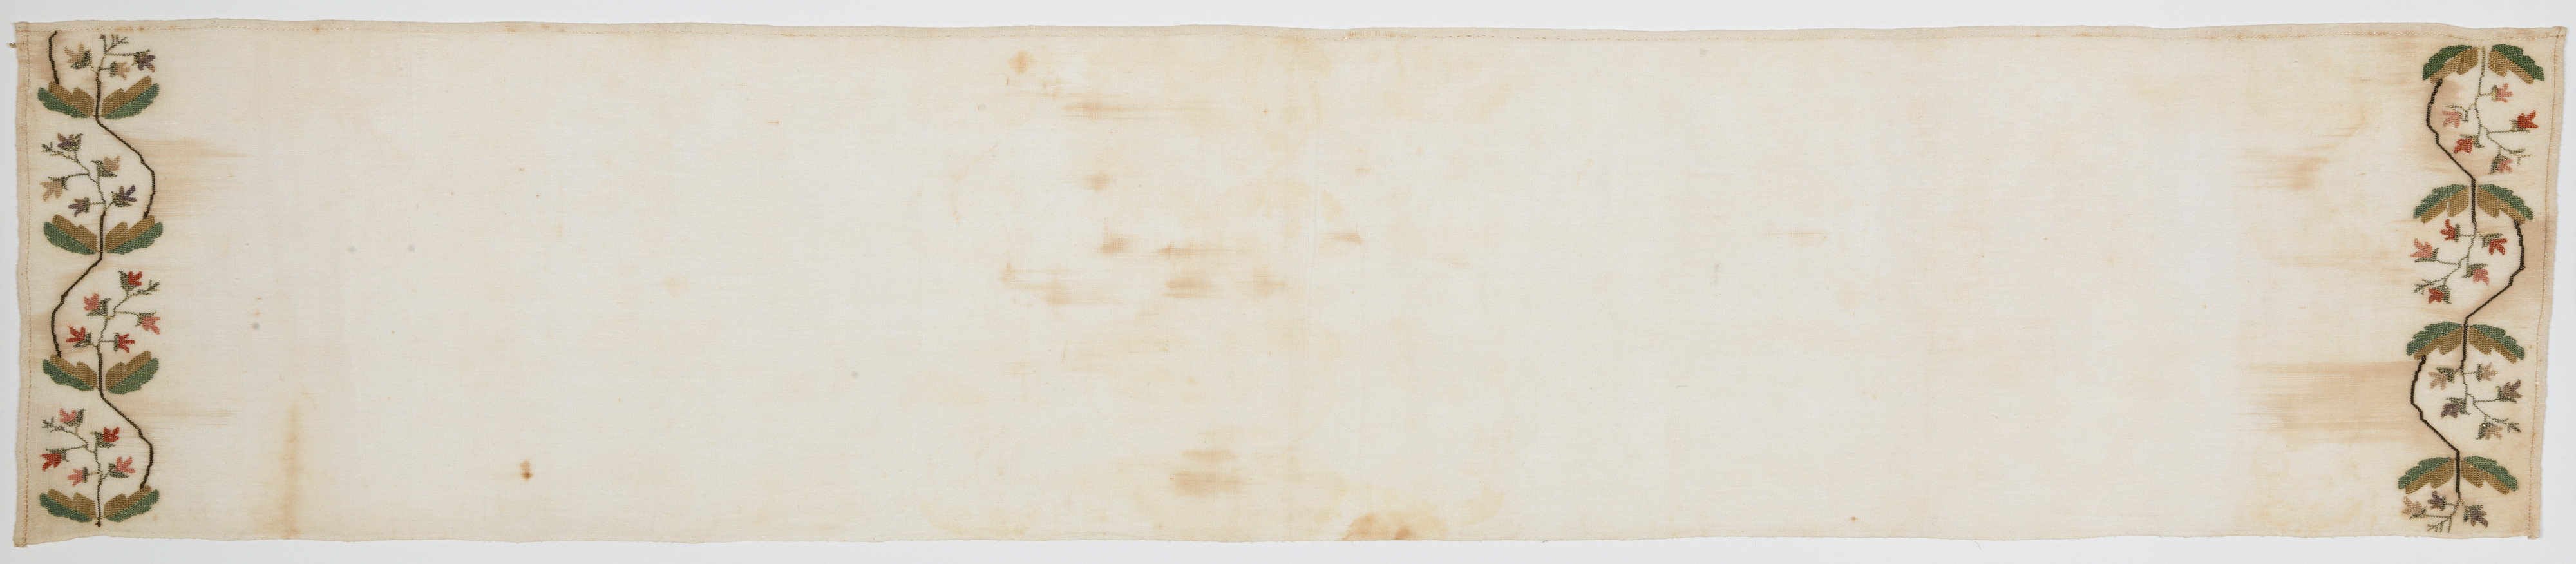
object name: sash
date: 1801-1900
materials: silk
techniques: embroidery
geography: turkey